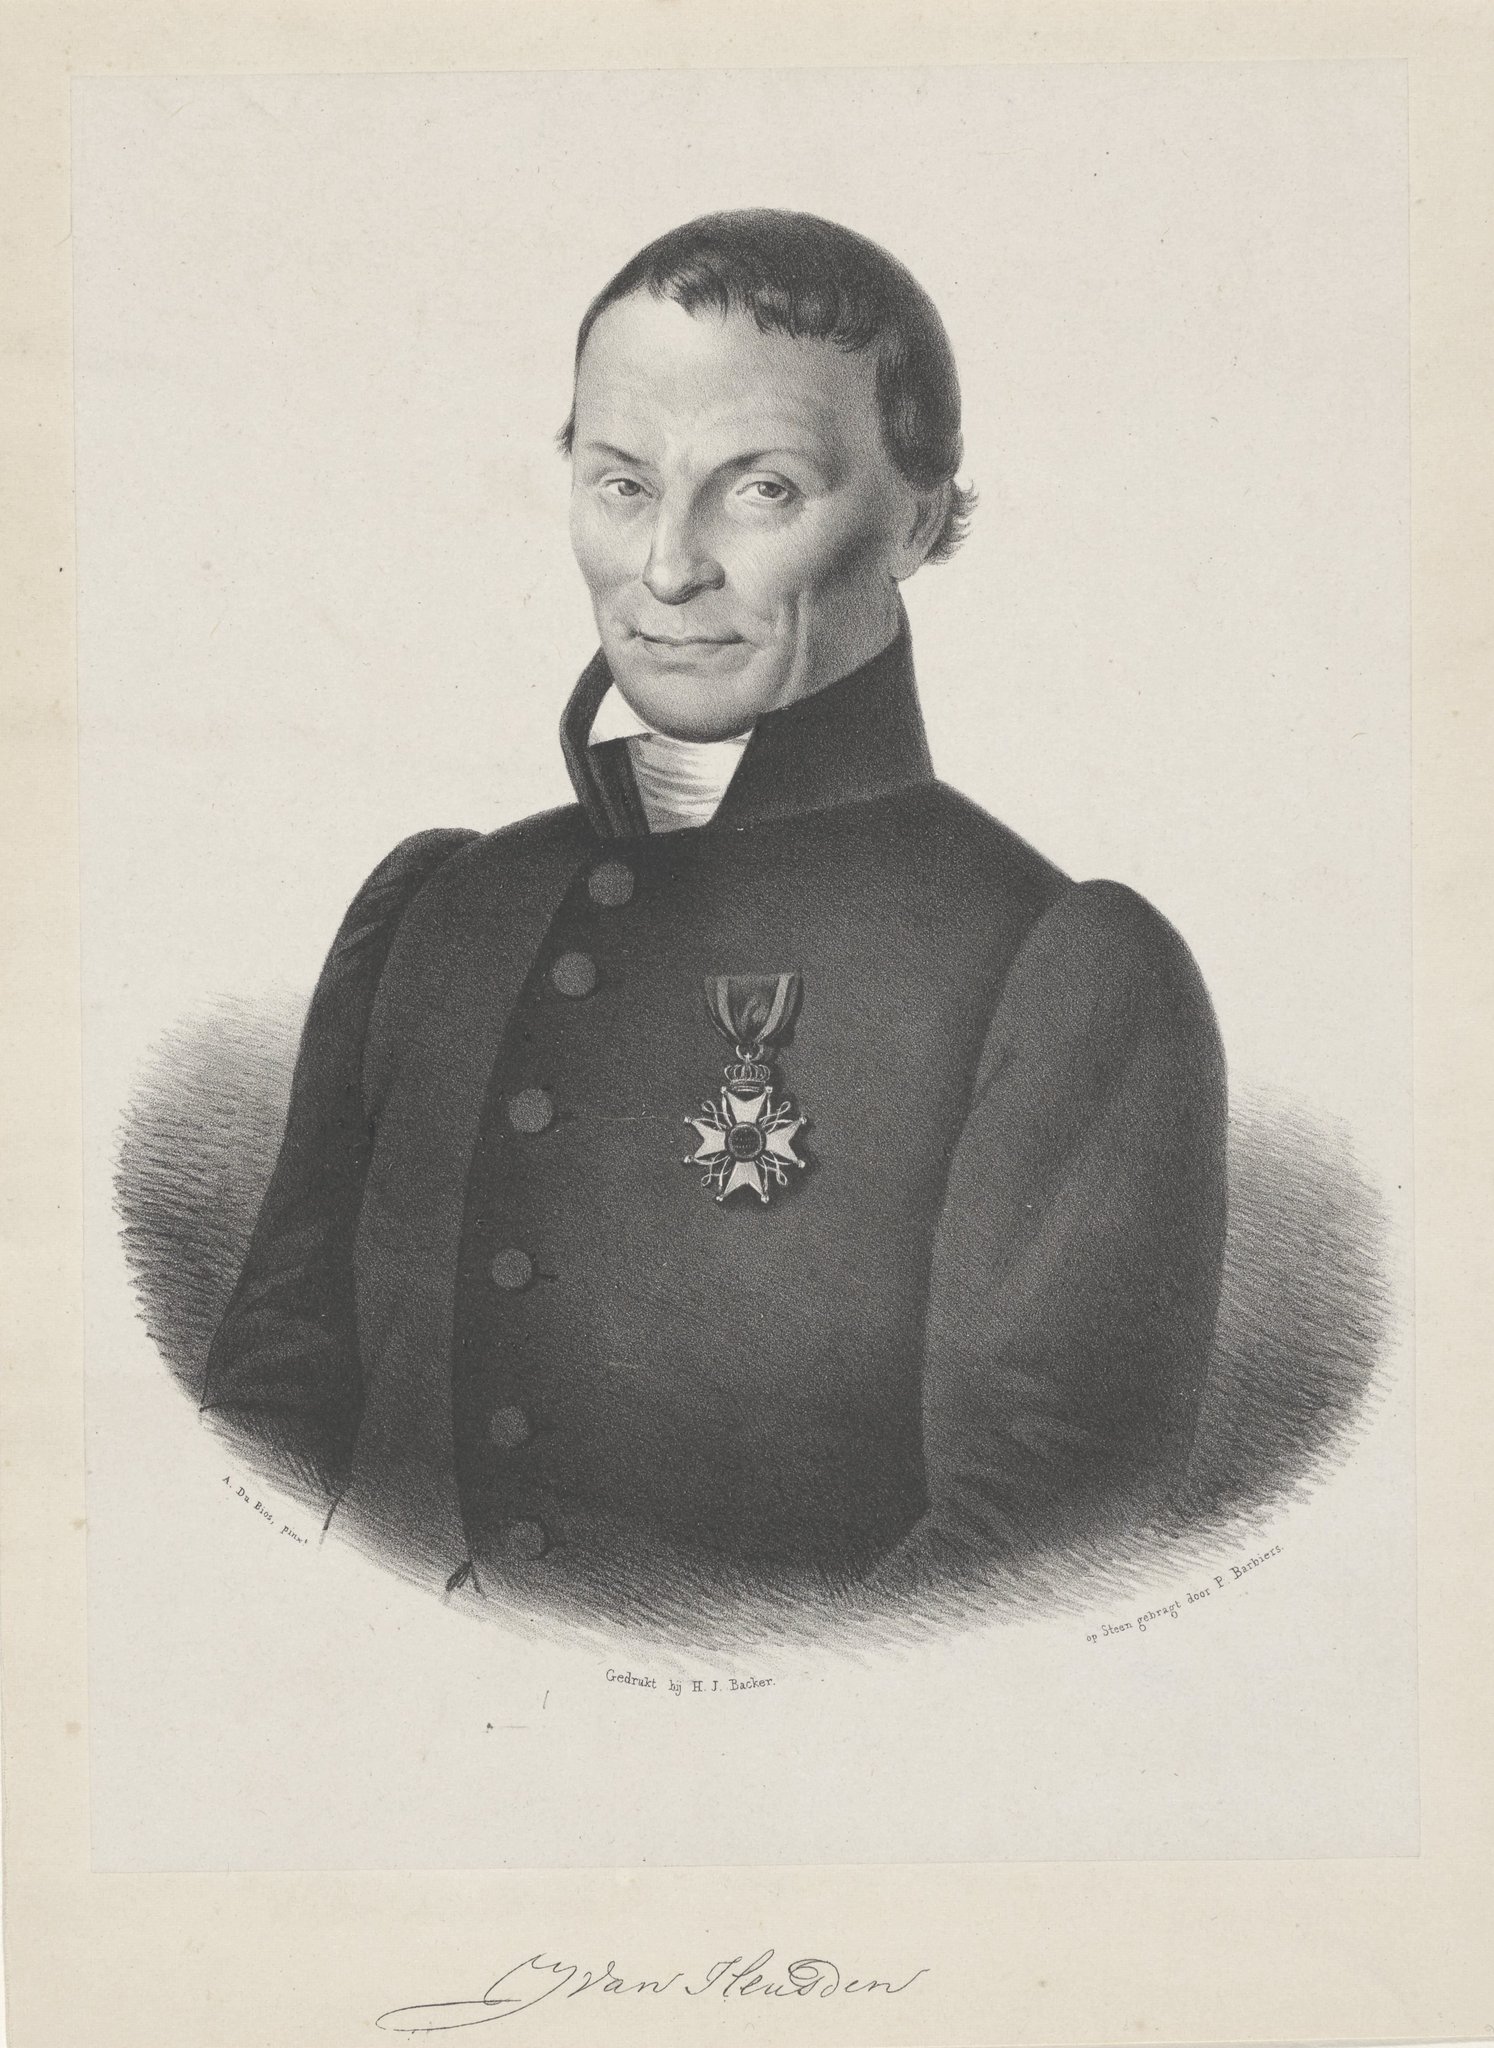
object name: print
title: Portret van predikant Cornelis Johannes van Heusden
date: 1822-1845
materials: paper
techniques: lithograph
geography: dordrecht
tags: brabant, den bosch, knighthood order, historical persons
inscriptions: collector's mark: Lugt 2228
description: Onder het portret de naam van de geportretteerde. Hij draagt een ridderorde.